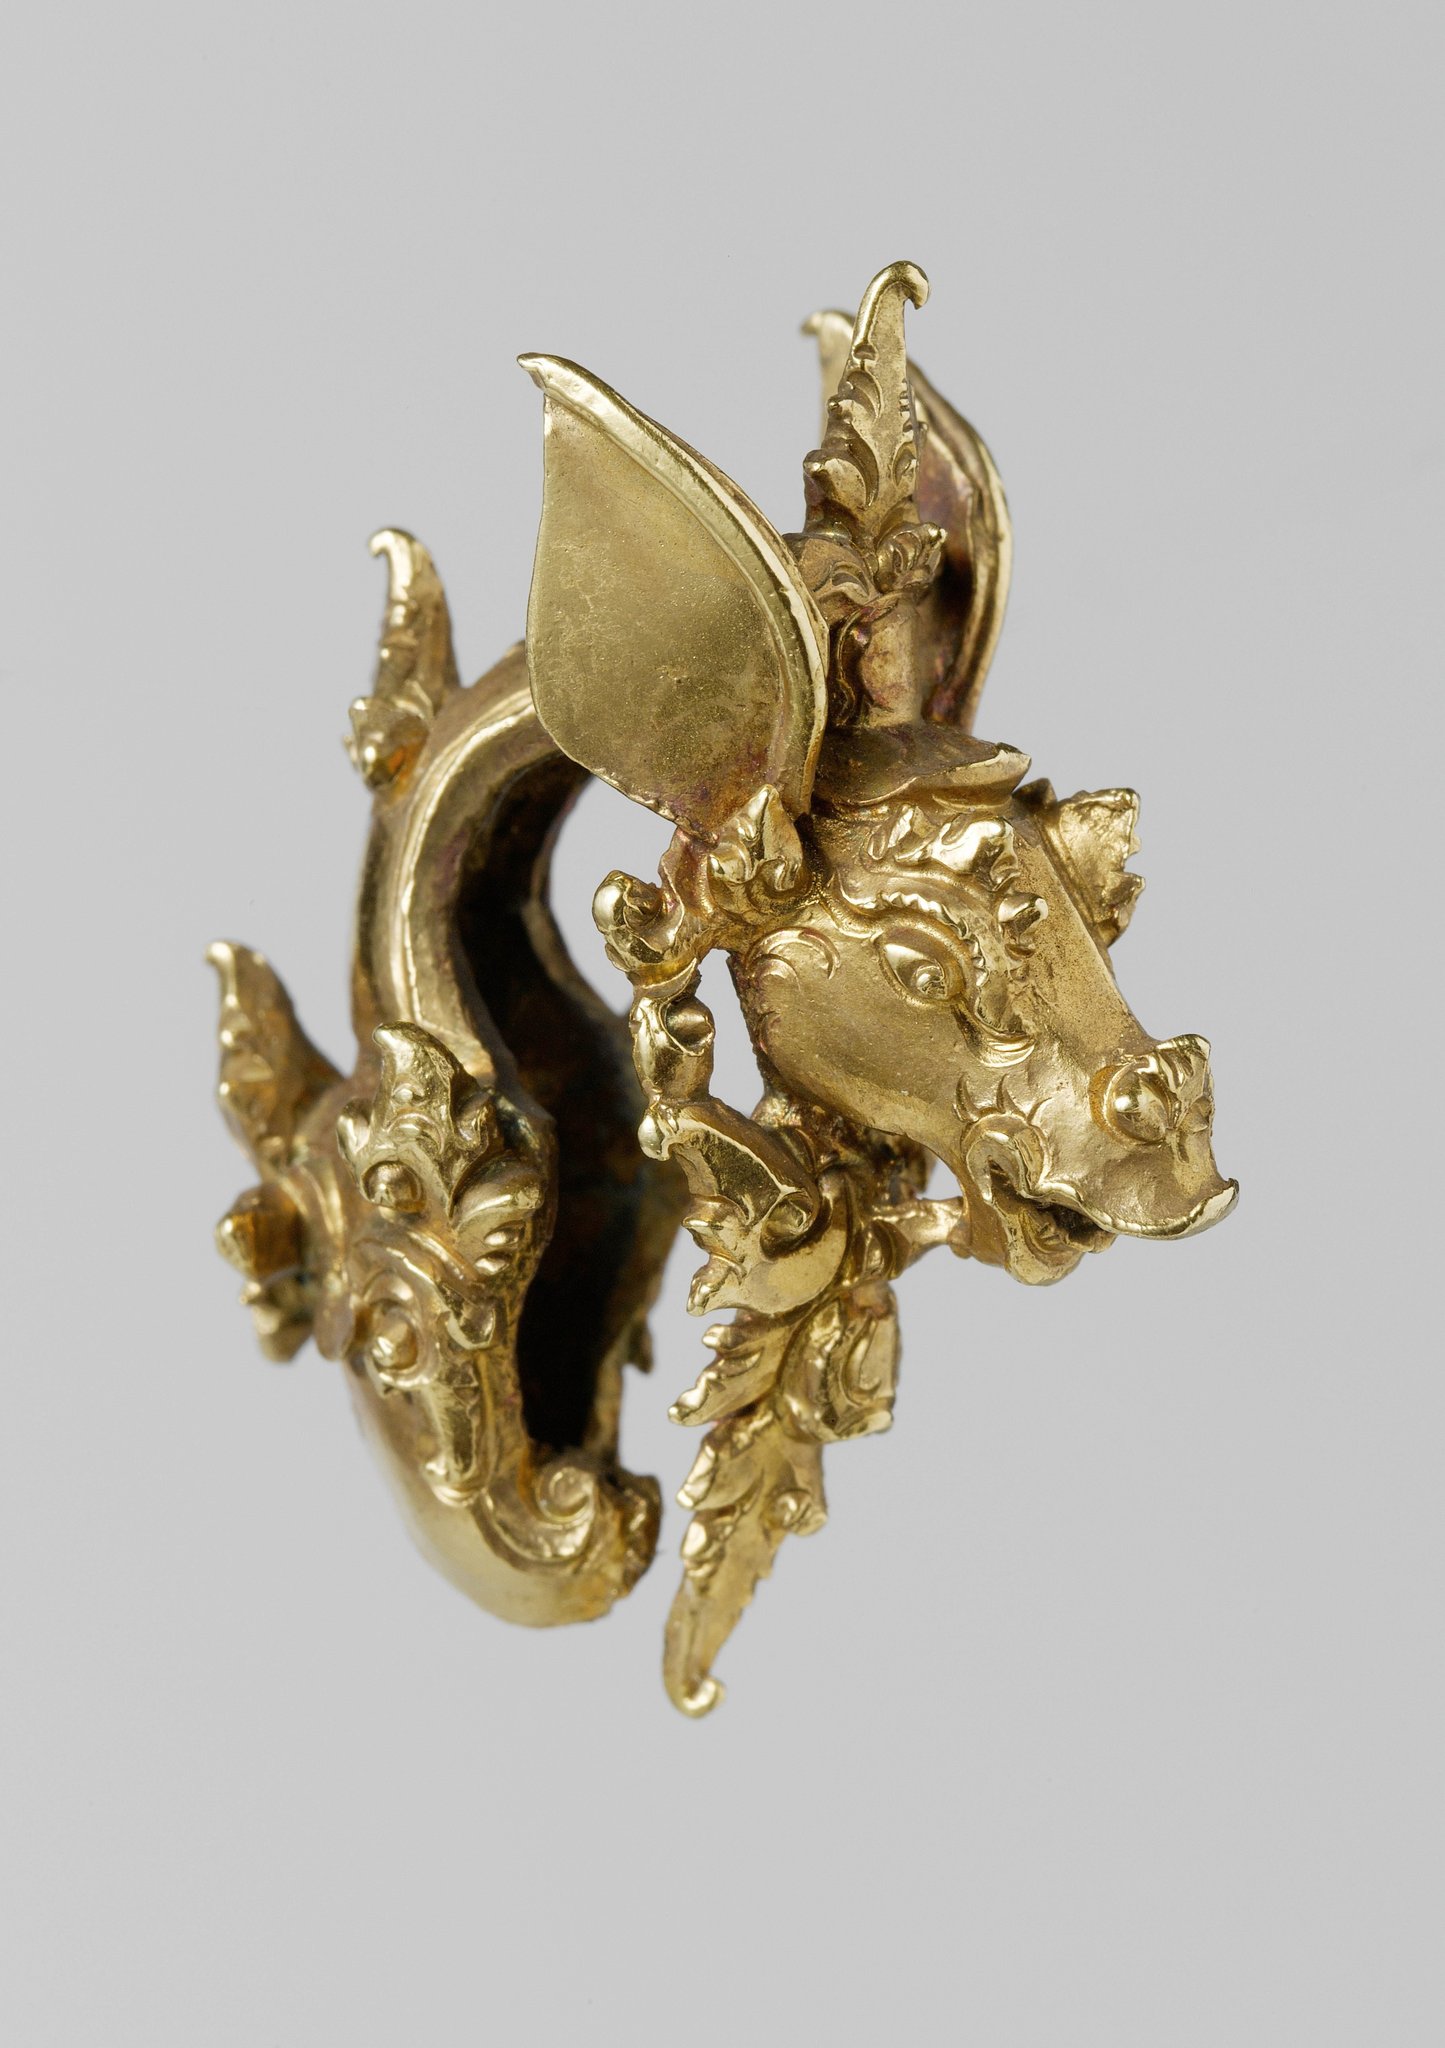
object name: jewellery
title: Earring with Animal Head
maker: Anonymous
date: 1300-1500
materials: gold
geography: java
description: Oorsieraad in de vorm van een paardenhoofd met flaporen waartussen een floraal ornament.